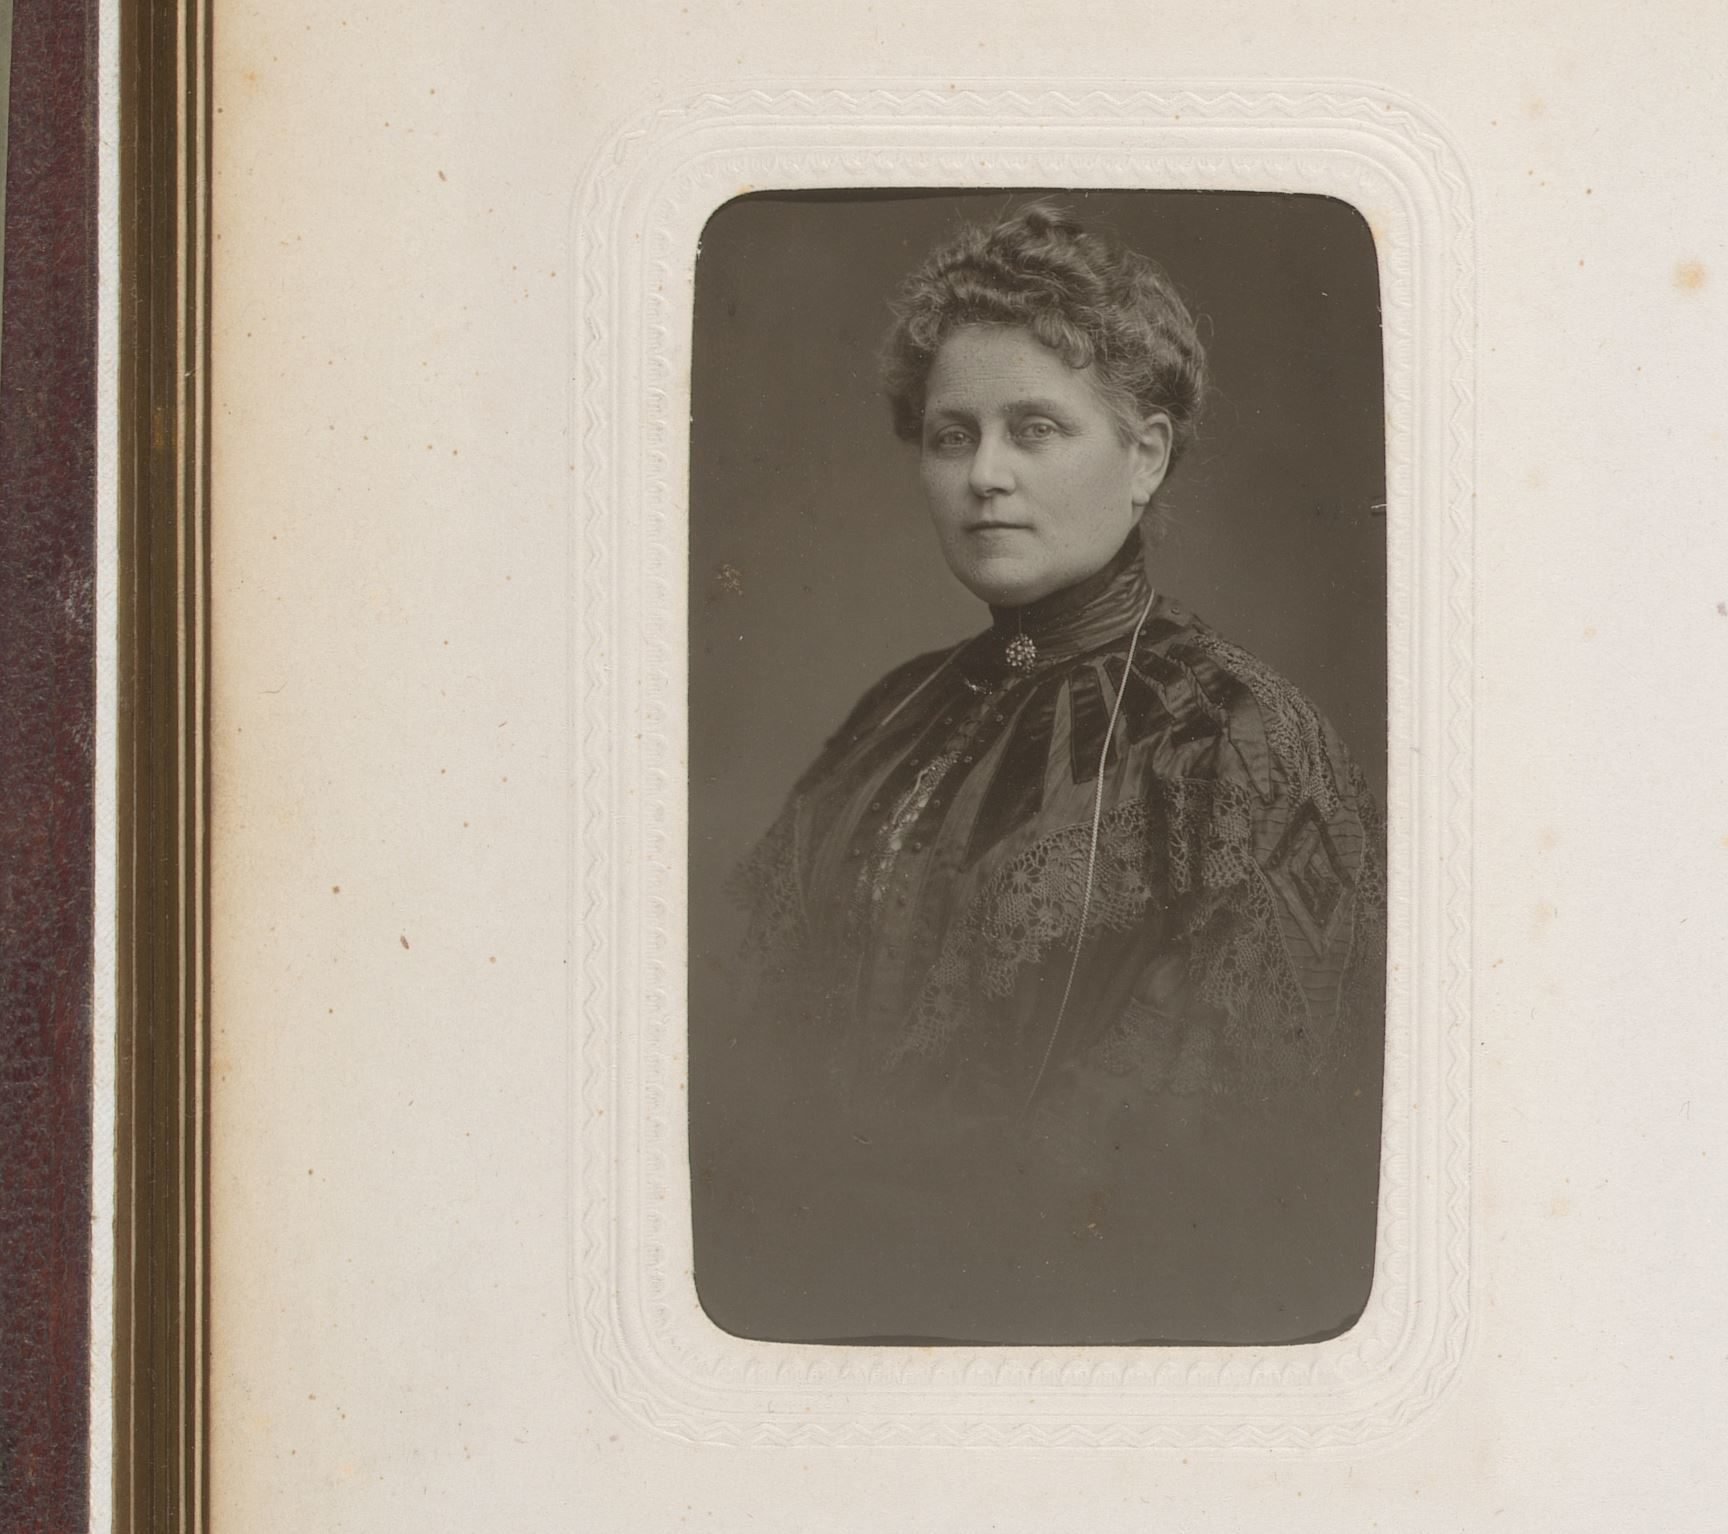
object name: photograph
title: Portret van een vrouw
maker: willy dose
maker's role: fotograaf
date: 1900-1910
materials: cardboard, photographic support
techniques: matte daylight collodion silver print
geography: bremen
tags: historical persons - bb - woman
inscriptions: inscription: ‘Willy Dose/ Photograph./ Bremen/ Wall 117.’